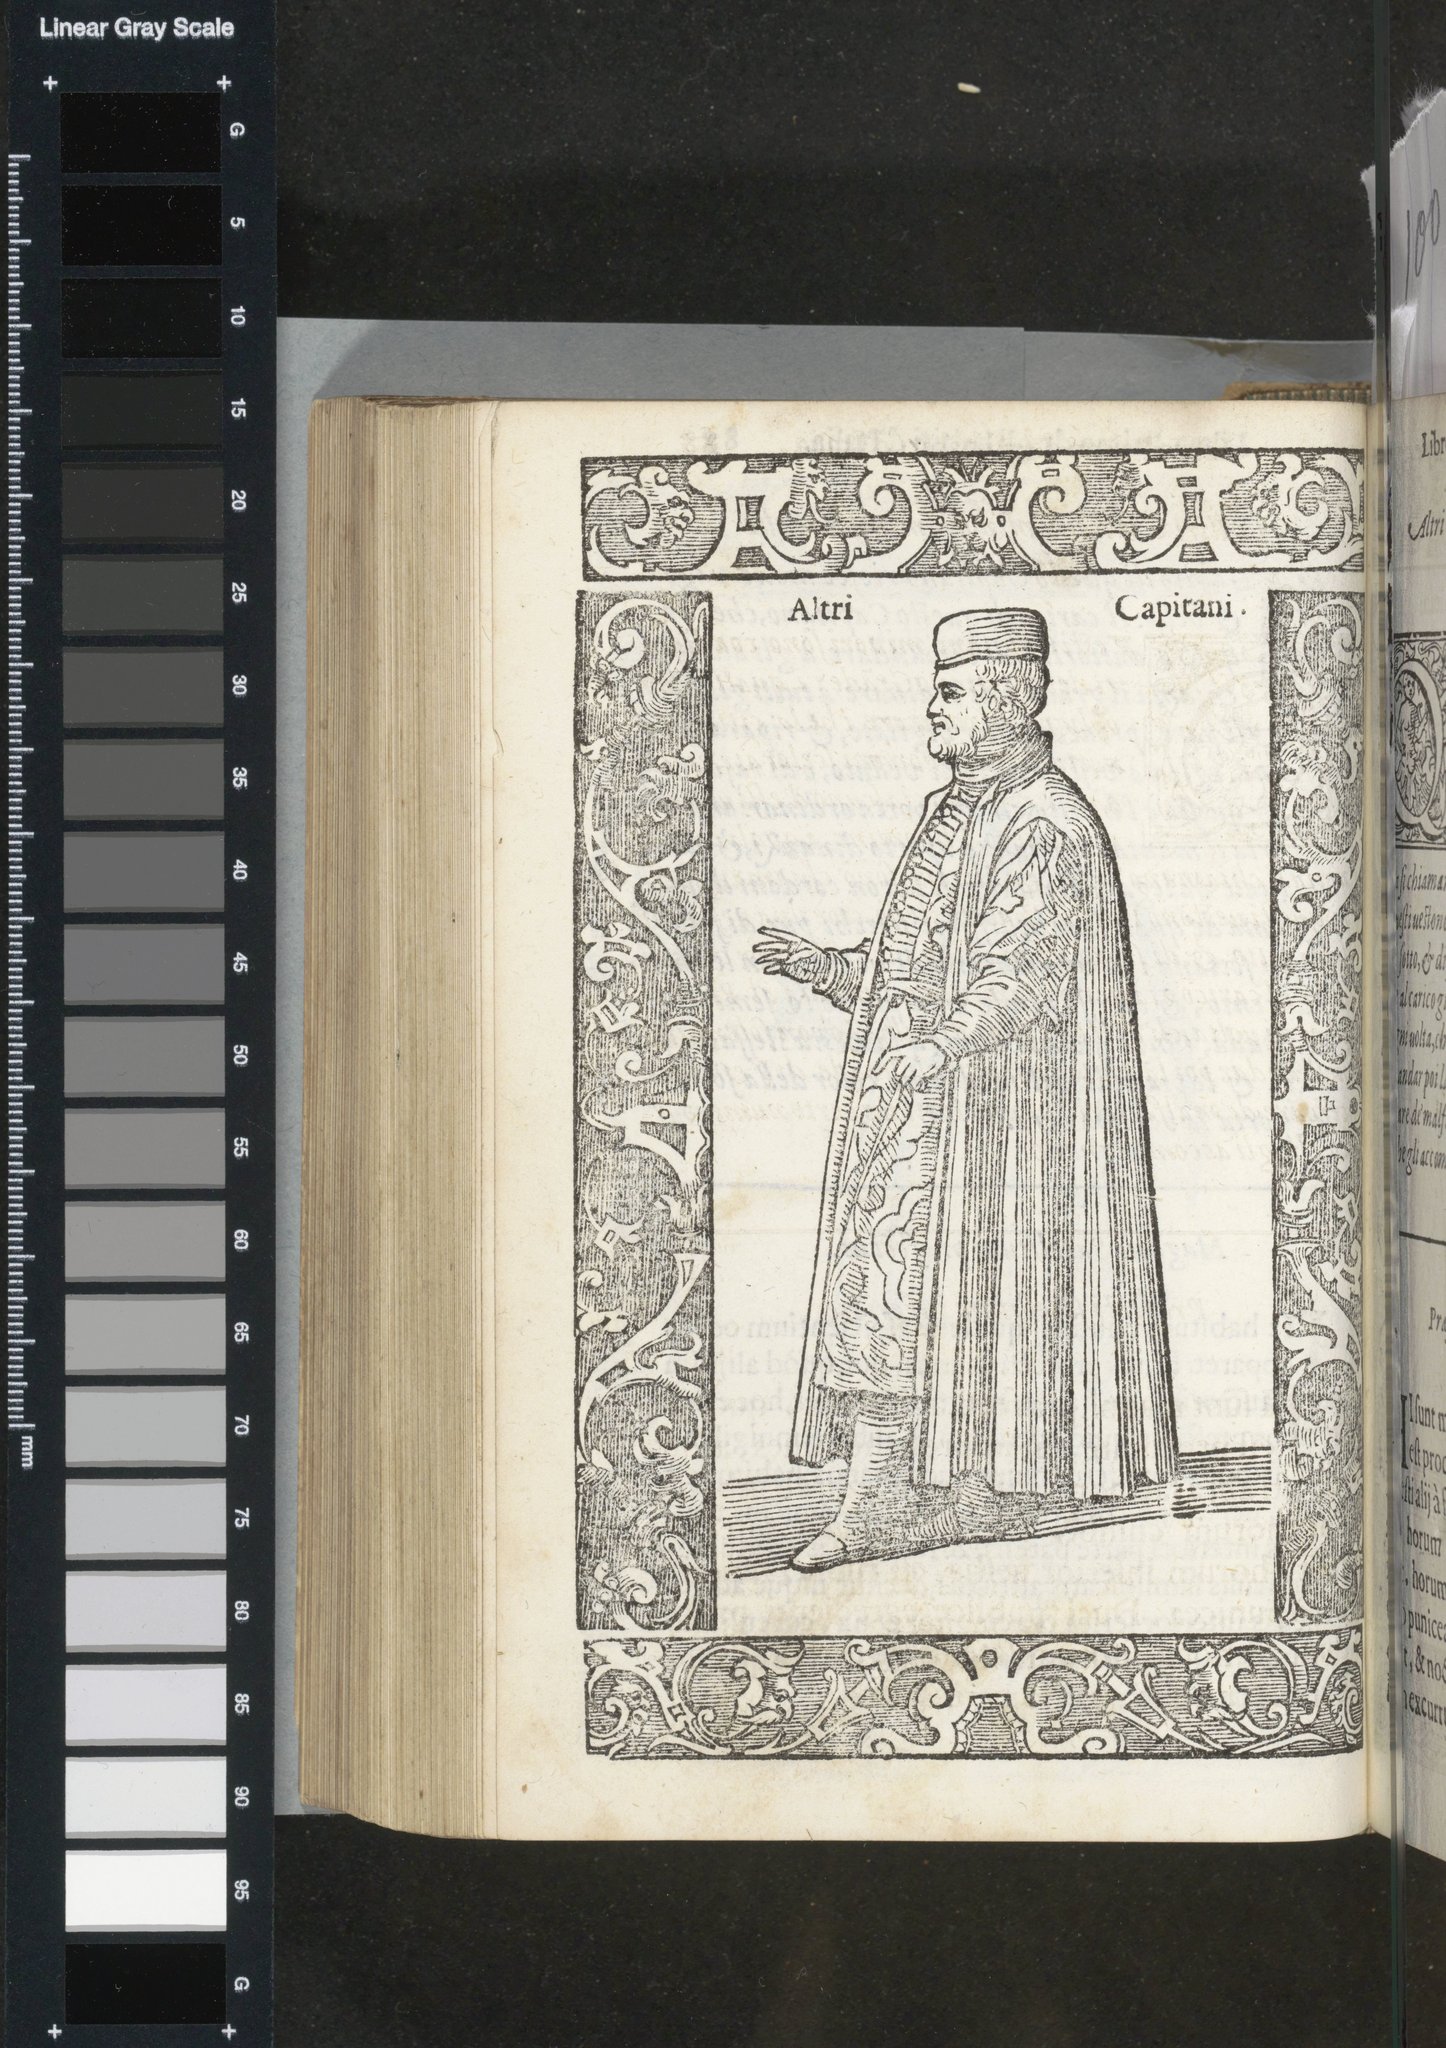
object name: costume print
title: Altri capitani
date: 1598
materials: paper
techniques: woodcut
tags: fashion plates